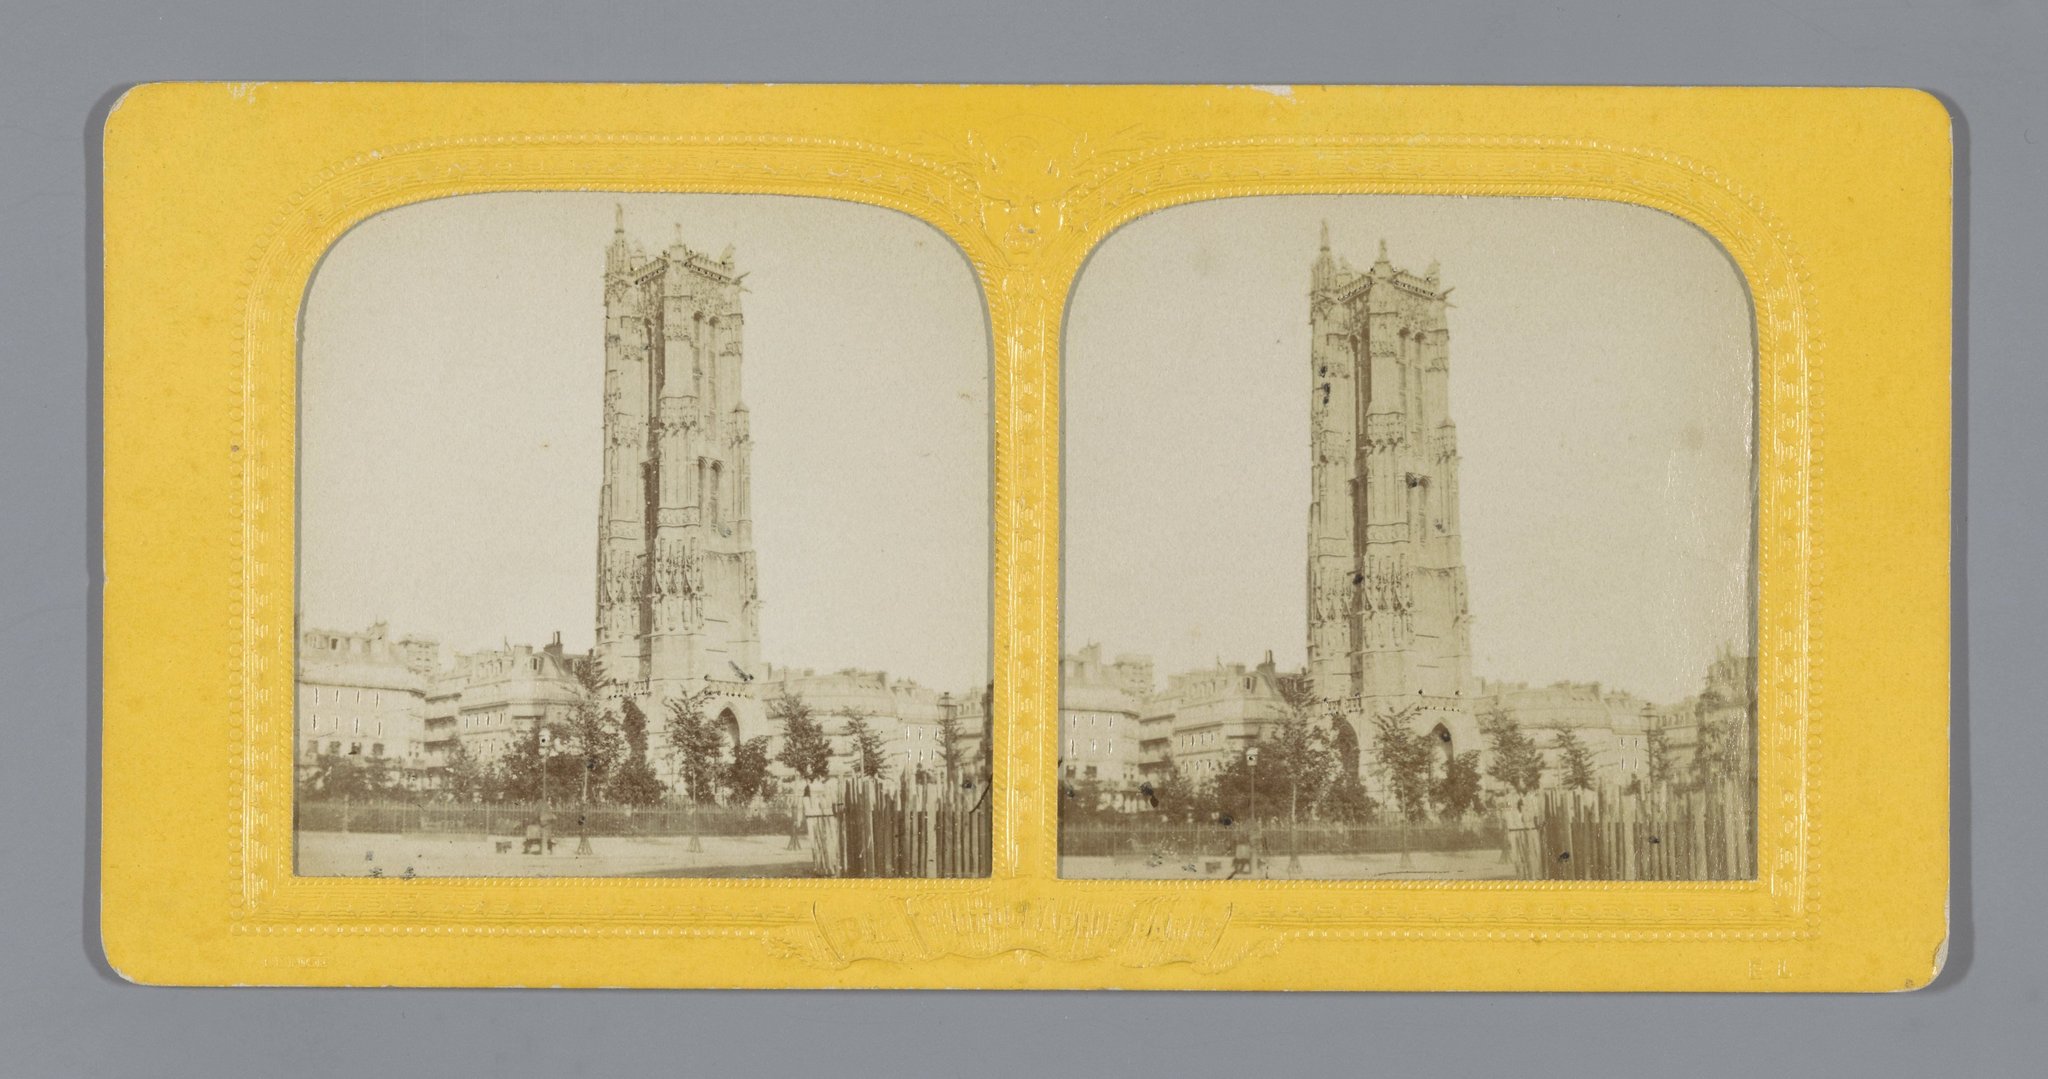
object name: tissue stereograph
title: Sint-Jacobstoren in Parijs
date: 1863-1875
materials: cardboard, paper, photographic support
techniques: albumen print, cutting, hand coloring, perforating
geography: paris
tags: parts of church exterior and annexes: tower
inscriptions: name: ‘B.K. PHOTOGRAPHIE PARIS’, monogram: ‘E.L.’